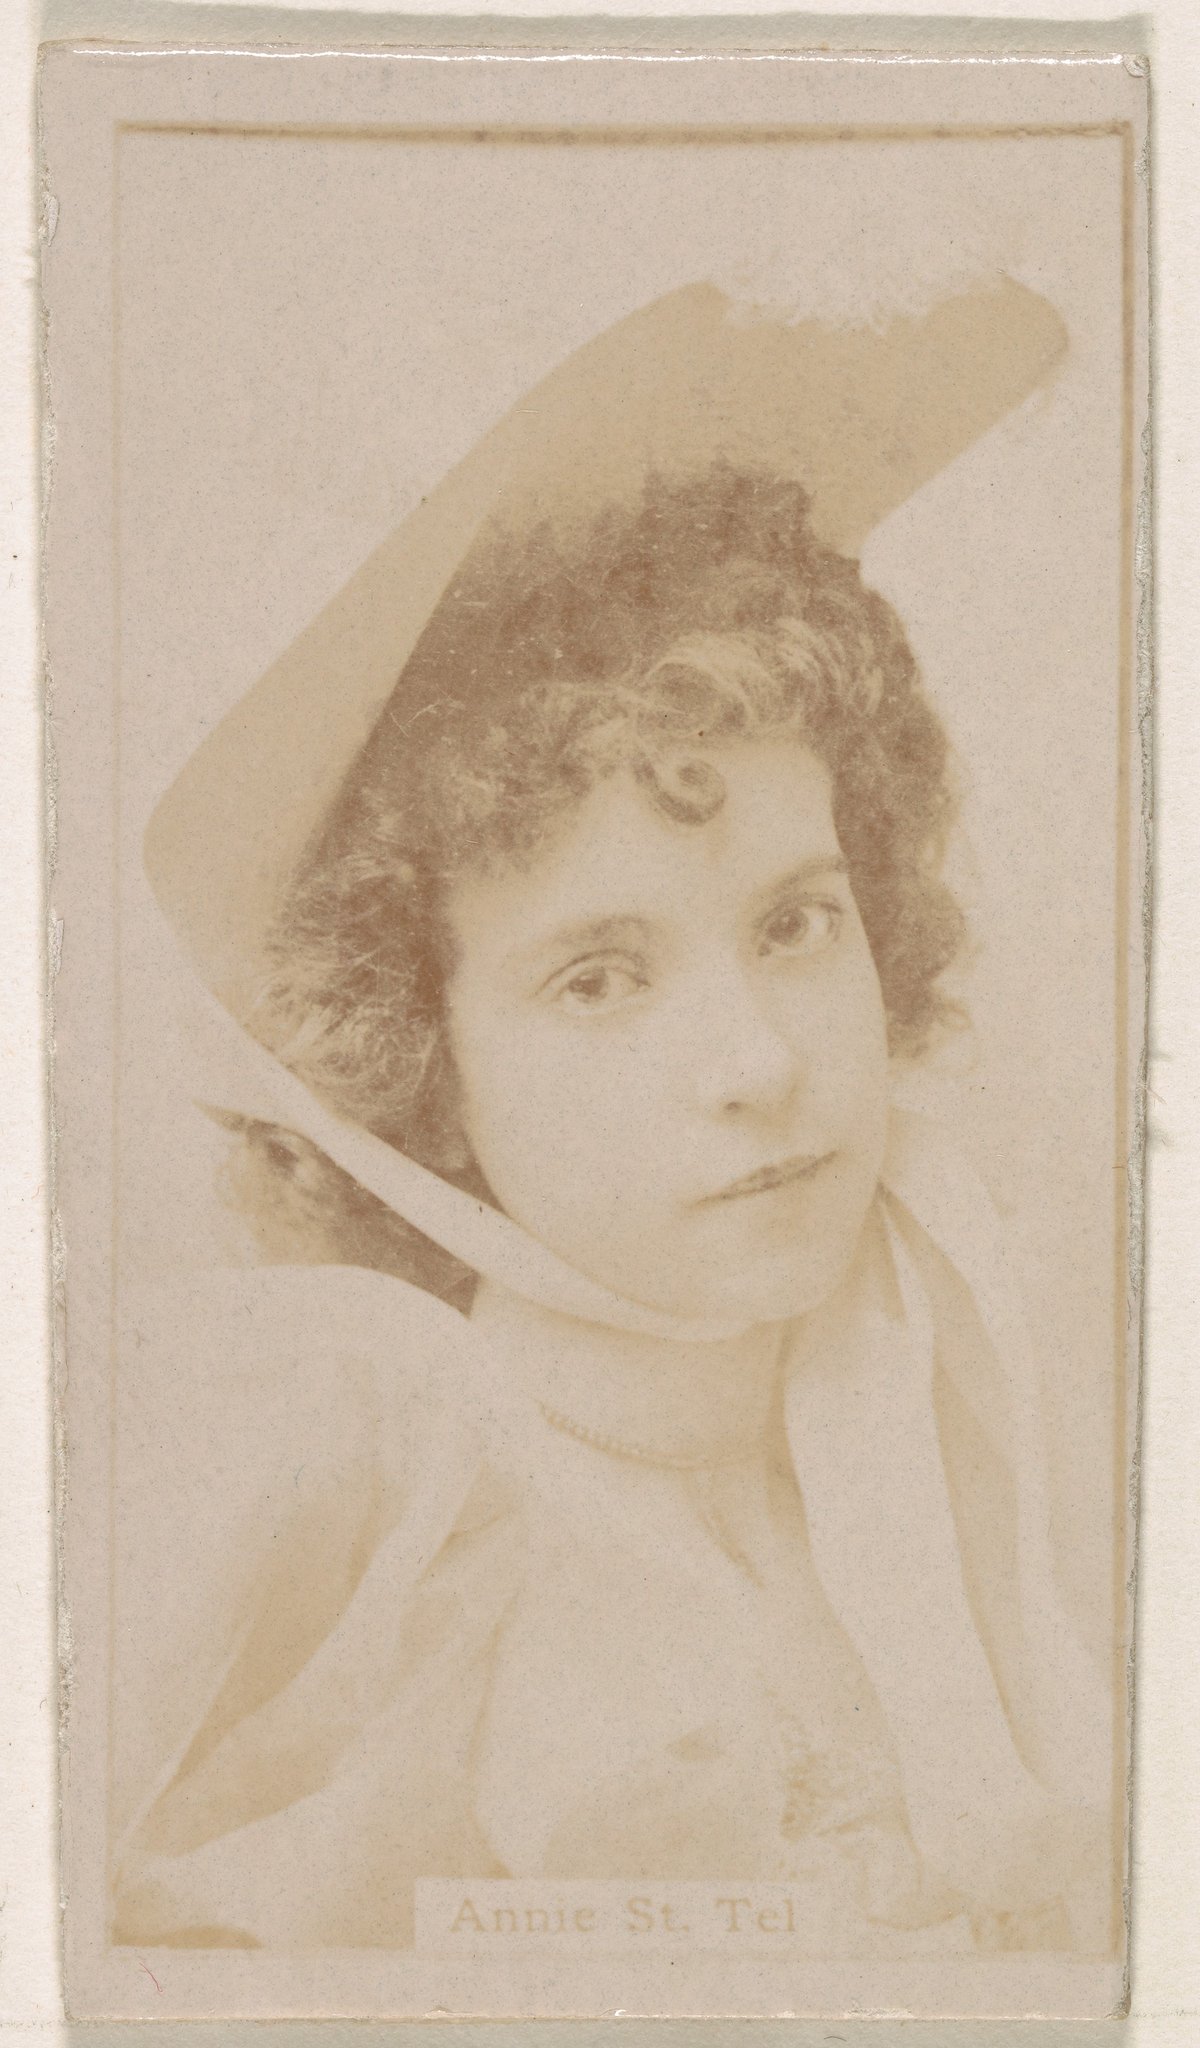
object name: photograph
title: Annie St. Tel, from the Actresses series (N245) issued by Kinney Brothers to promote Sweet Caporal Cigarettes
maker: kinney brothers tobacco company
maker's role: publisher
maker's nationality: american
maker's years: 1869-2011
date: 1890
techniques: albumen silver print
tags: portraits,women,actresses